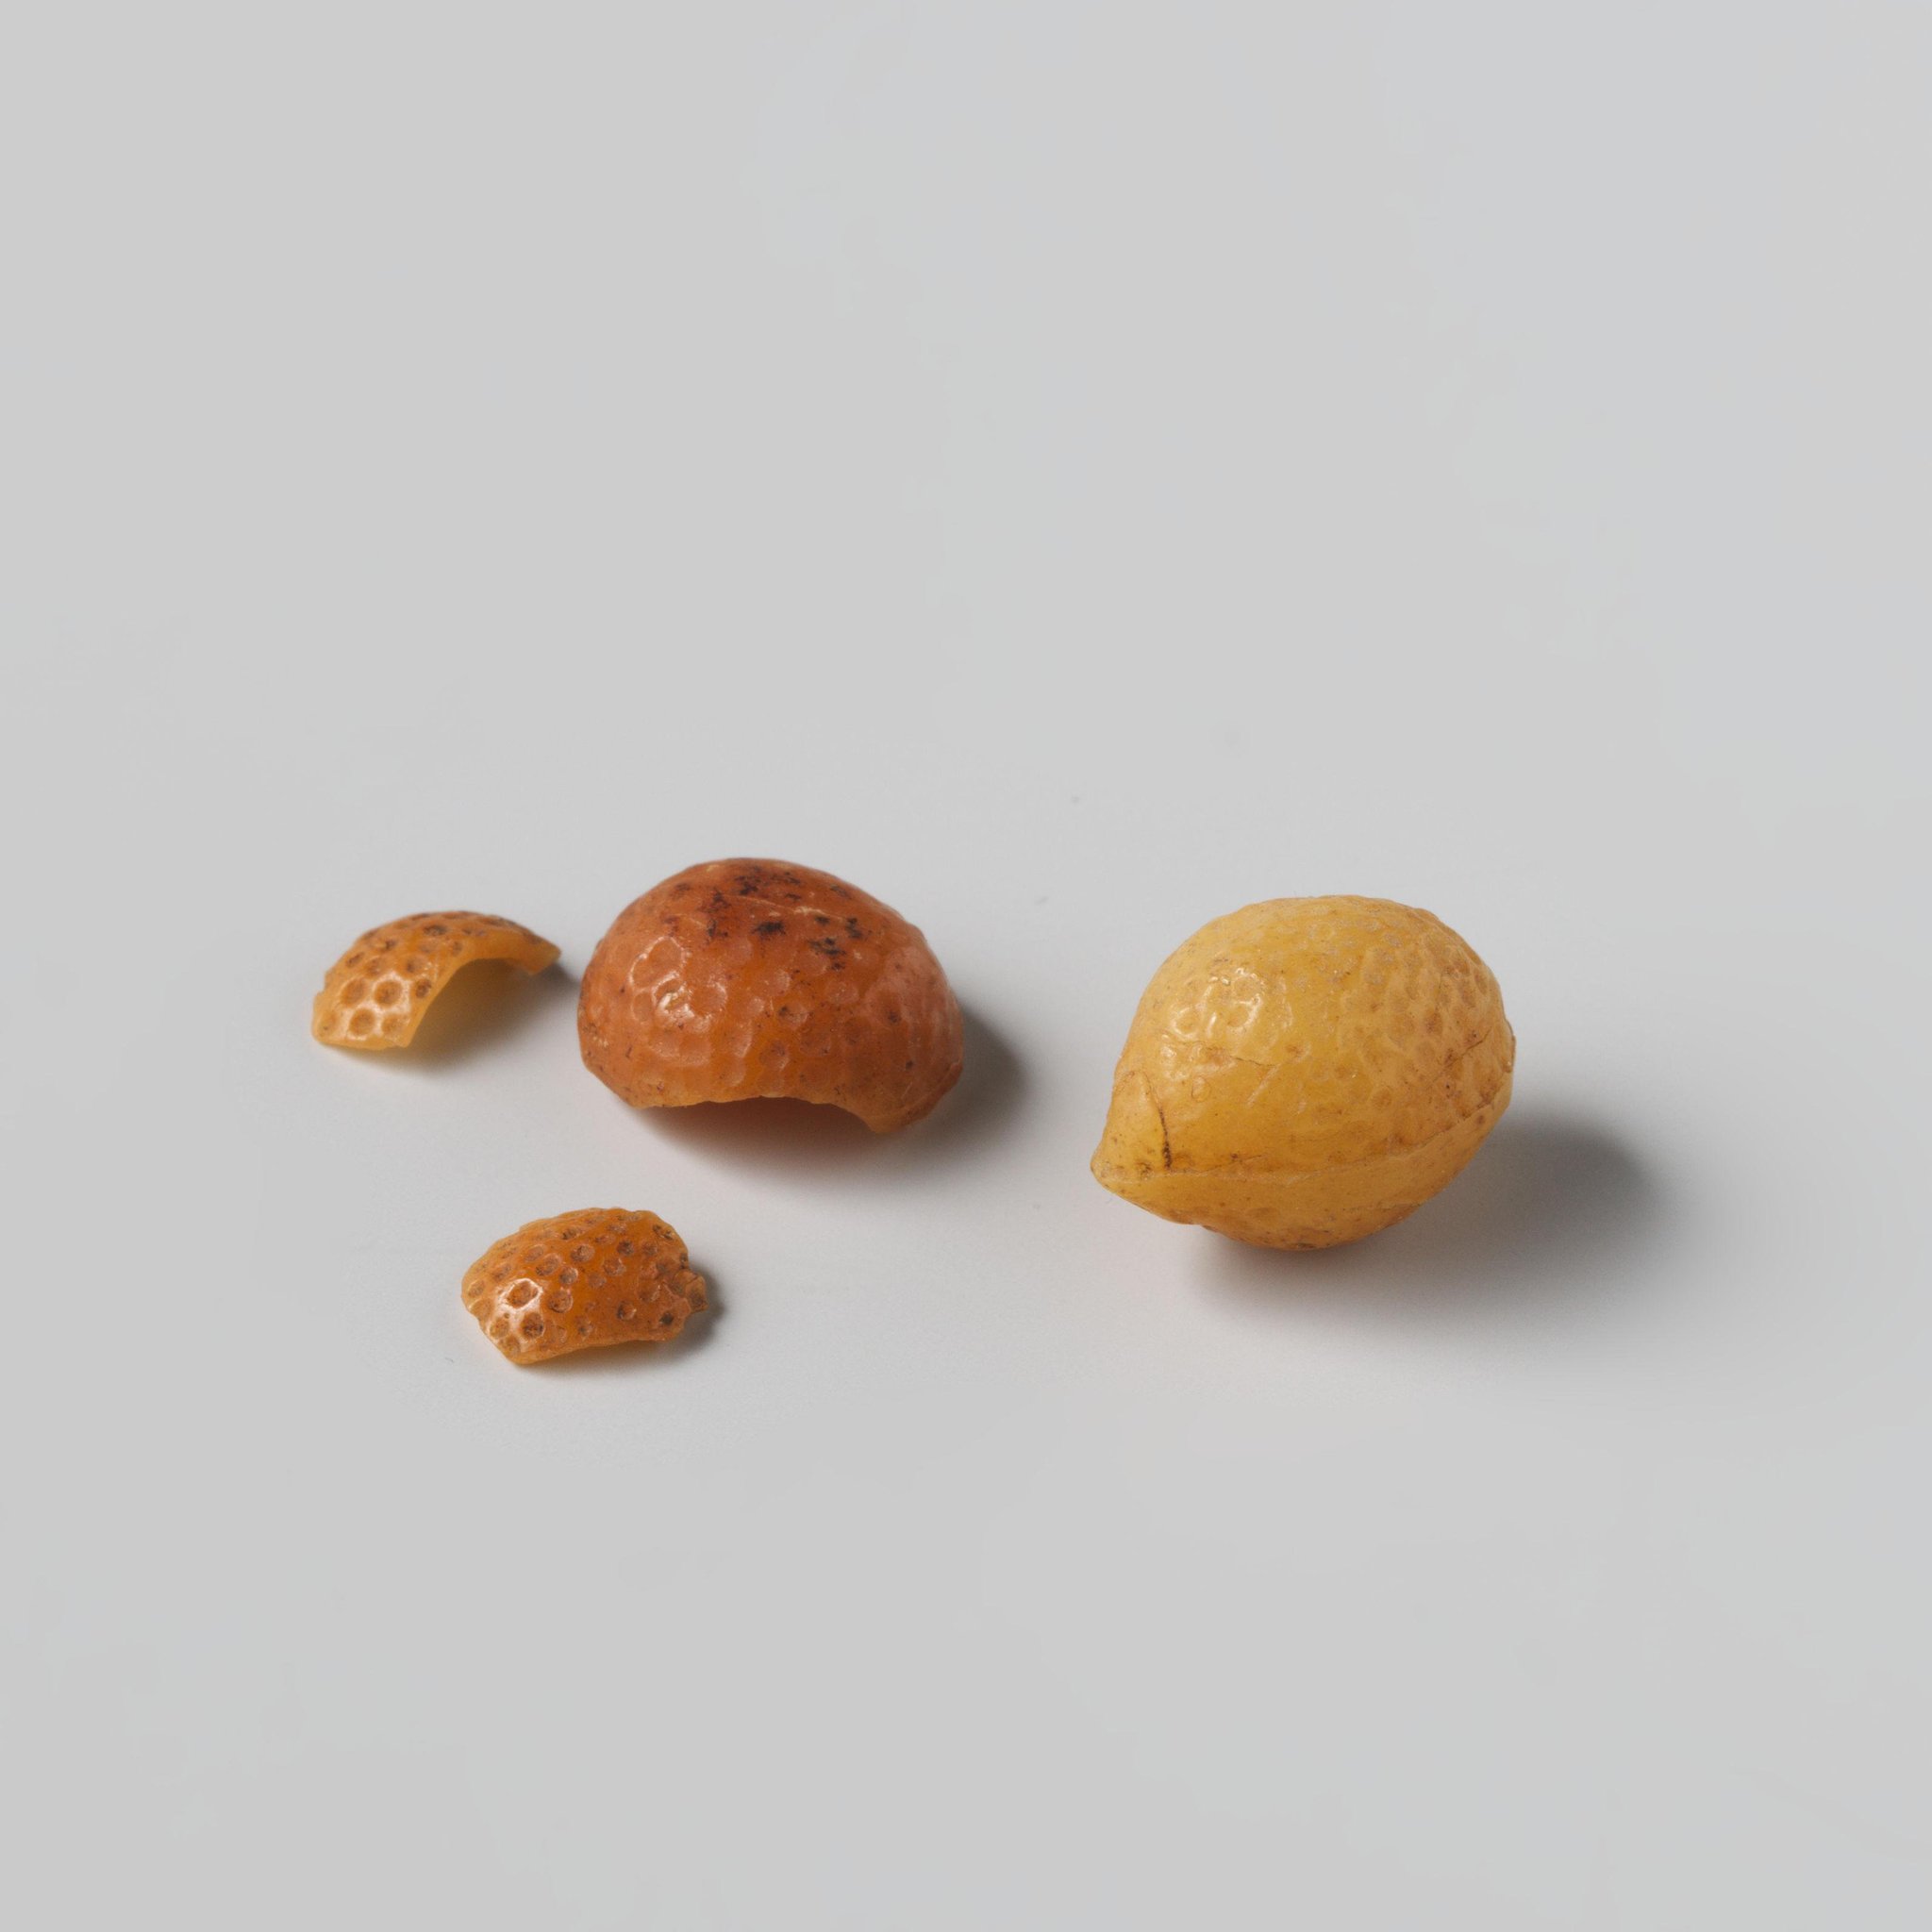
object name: miniature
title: Vruchten, waaronder een citroen en een sinaasappel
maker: Anonymous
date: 1675-1699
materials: wax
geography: amsterdam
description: Vruchten en delen van vruchten, vervaardigd van was, waaronder een citroen en een sinaasappel.